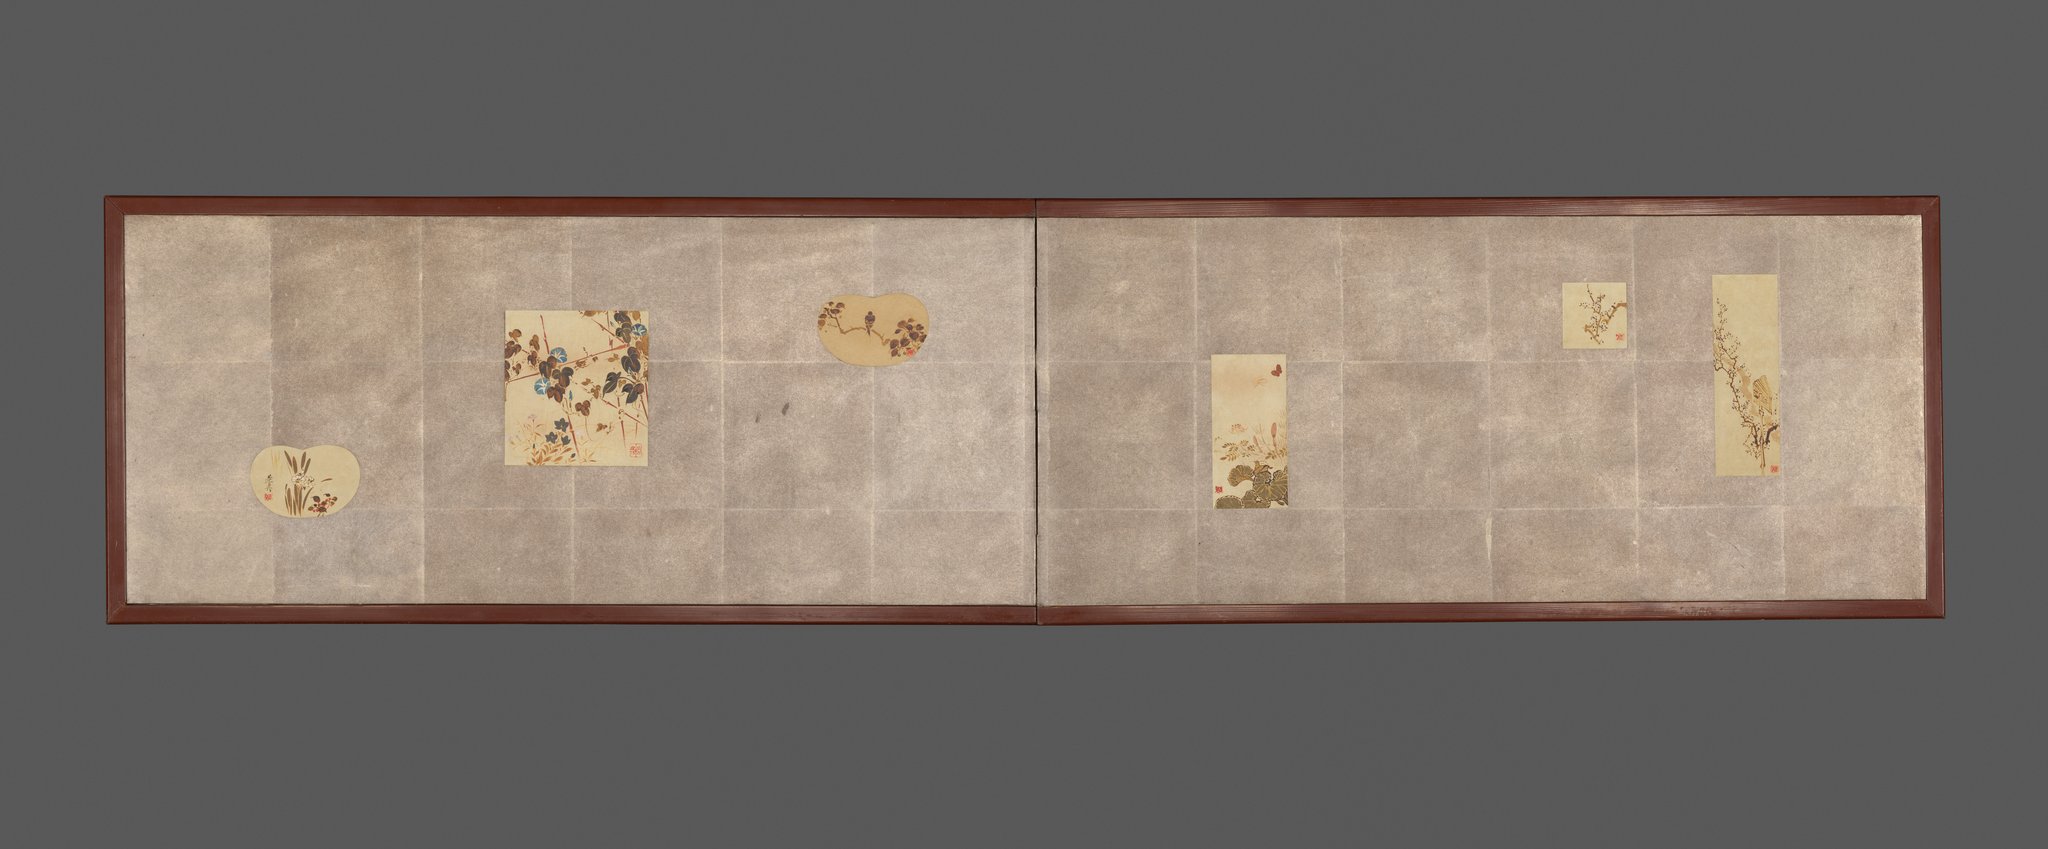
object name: screen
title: Folding Screen for Tea Ceremony with Six Bird-and-Flower Paintings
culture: japanese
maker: shibata zeshin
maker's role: artist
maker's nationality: japanese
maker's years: 1807-1891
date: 1867-1900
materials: lacquer, panel, paper, silver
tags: birds,flowers,leaves